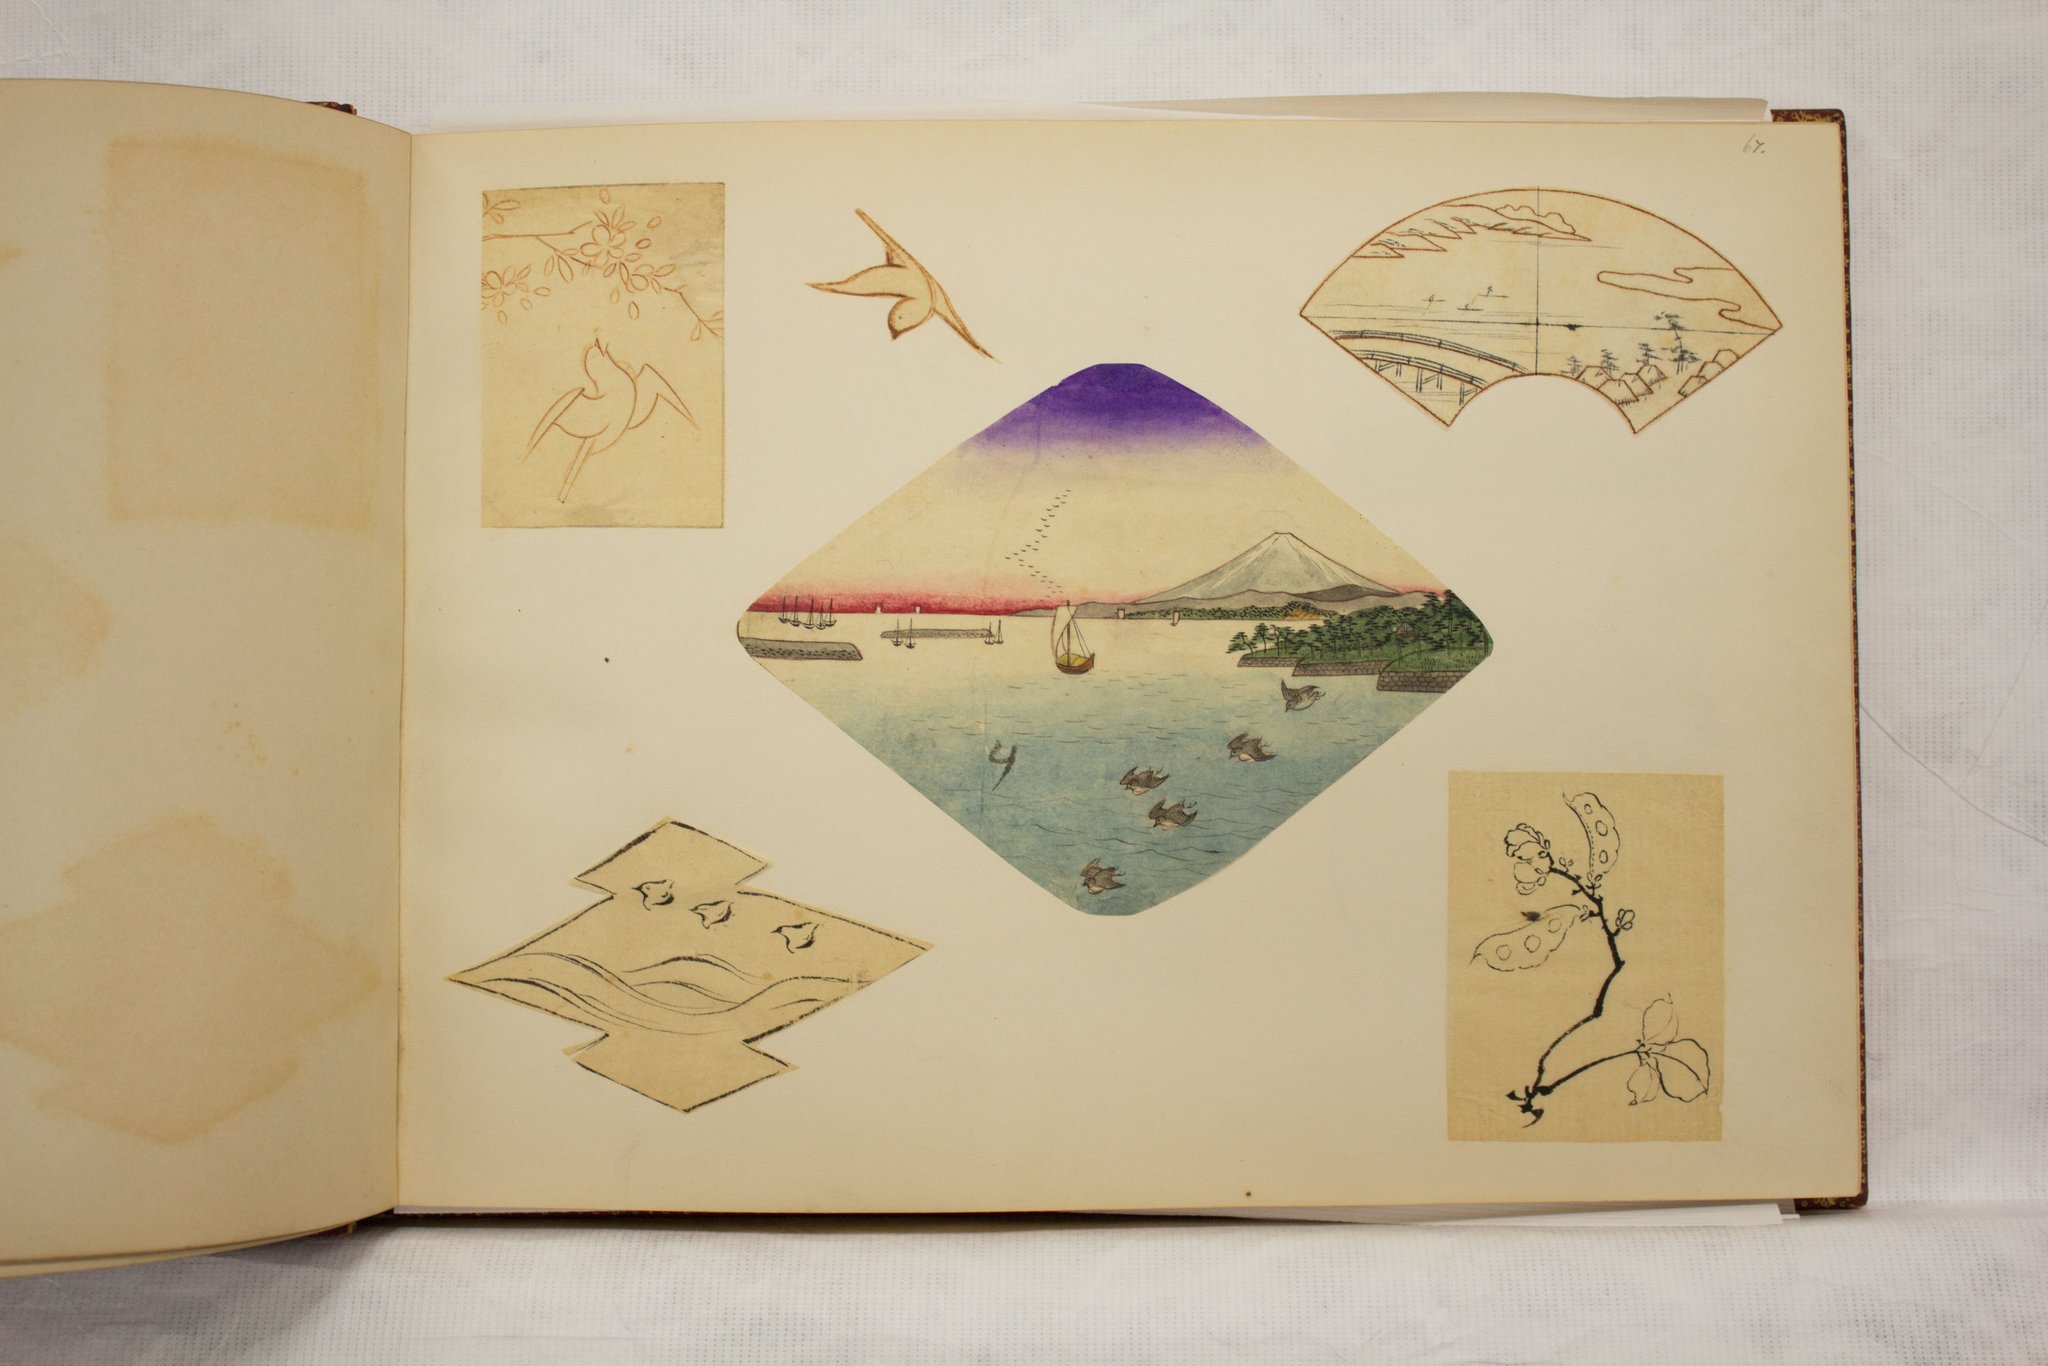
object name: album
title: Album of Sketches and Drawings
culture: japanese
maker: unidentified artist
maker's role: artist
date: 1801-1900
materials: ink, paper